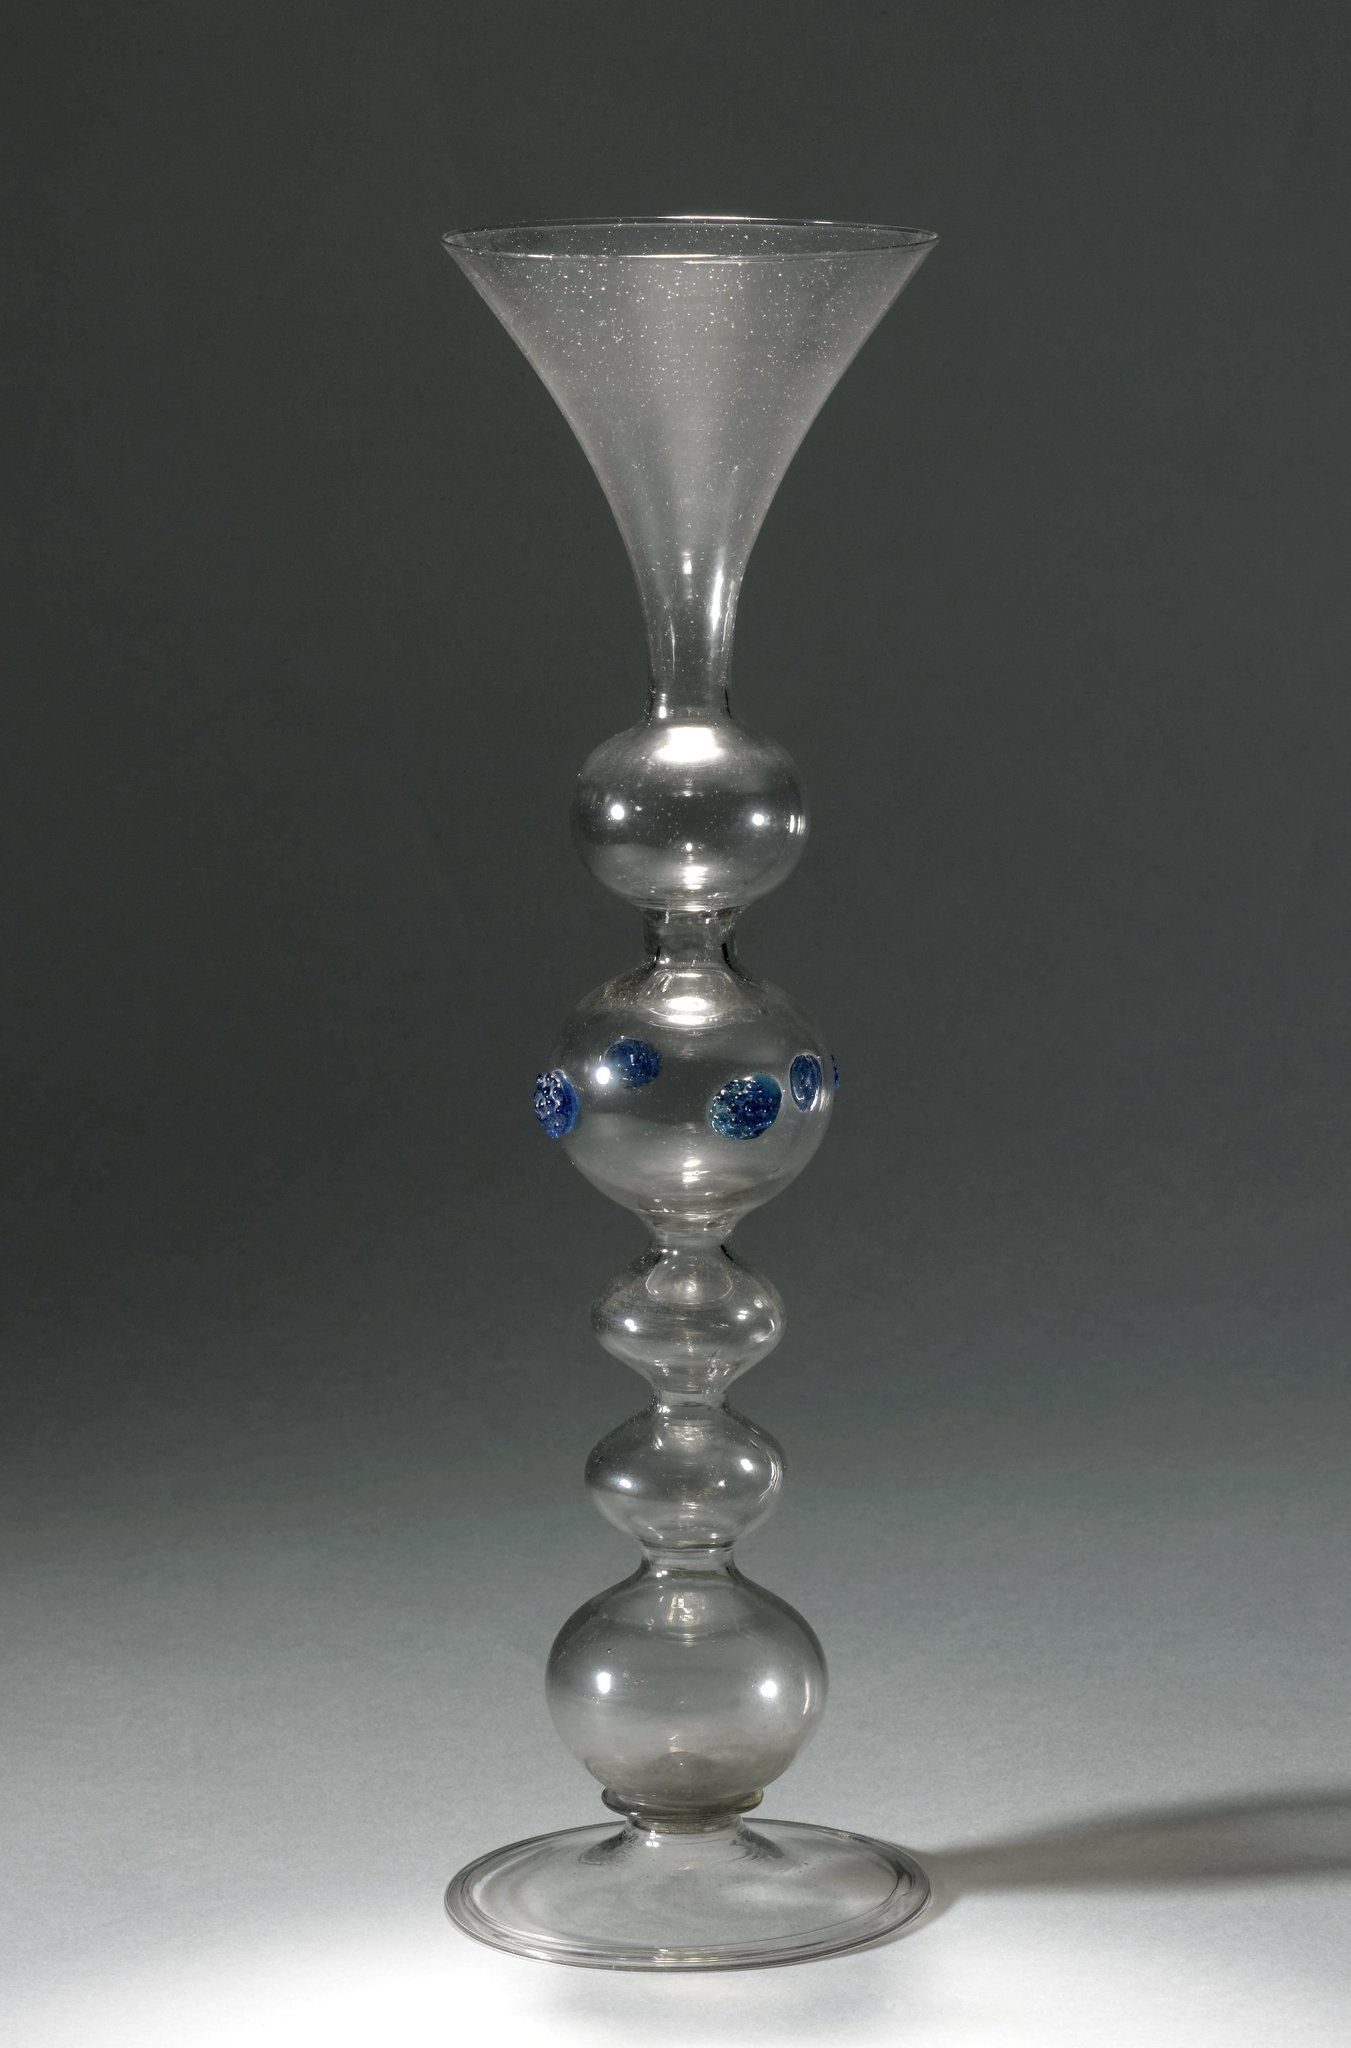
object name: goblet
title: Kelkglas met een holle stam met vijf bollen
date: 1600-1650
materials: glass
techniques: façon de venise, glassblowing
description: Façon de Venise translates literally as 'in the manner of Venice'. Venetian glass-blowers rose to great fame in the 16th century, for they were the only craftsmen who could produce colourless glass of exquisite delicacy of structure and form. When Venetian glass-blowers set up workshops in Germany, France, England and Holland, their technique was imitated in those countries. These non-Italian products are of such high quality that it is often hard to distinguish glass á la façon de Venise from the genuine article. Wine glass. Venice or Netherlands, façon de Venise, c. 1600-1650.